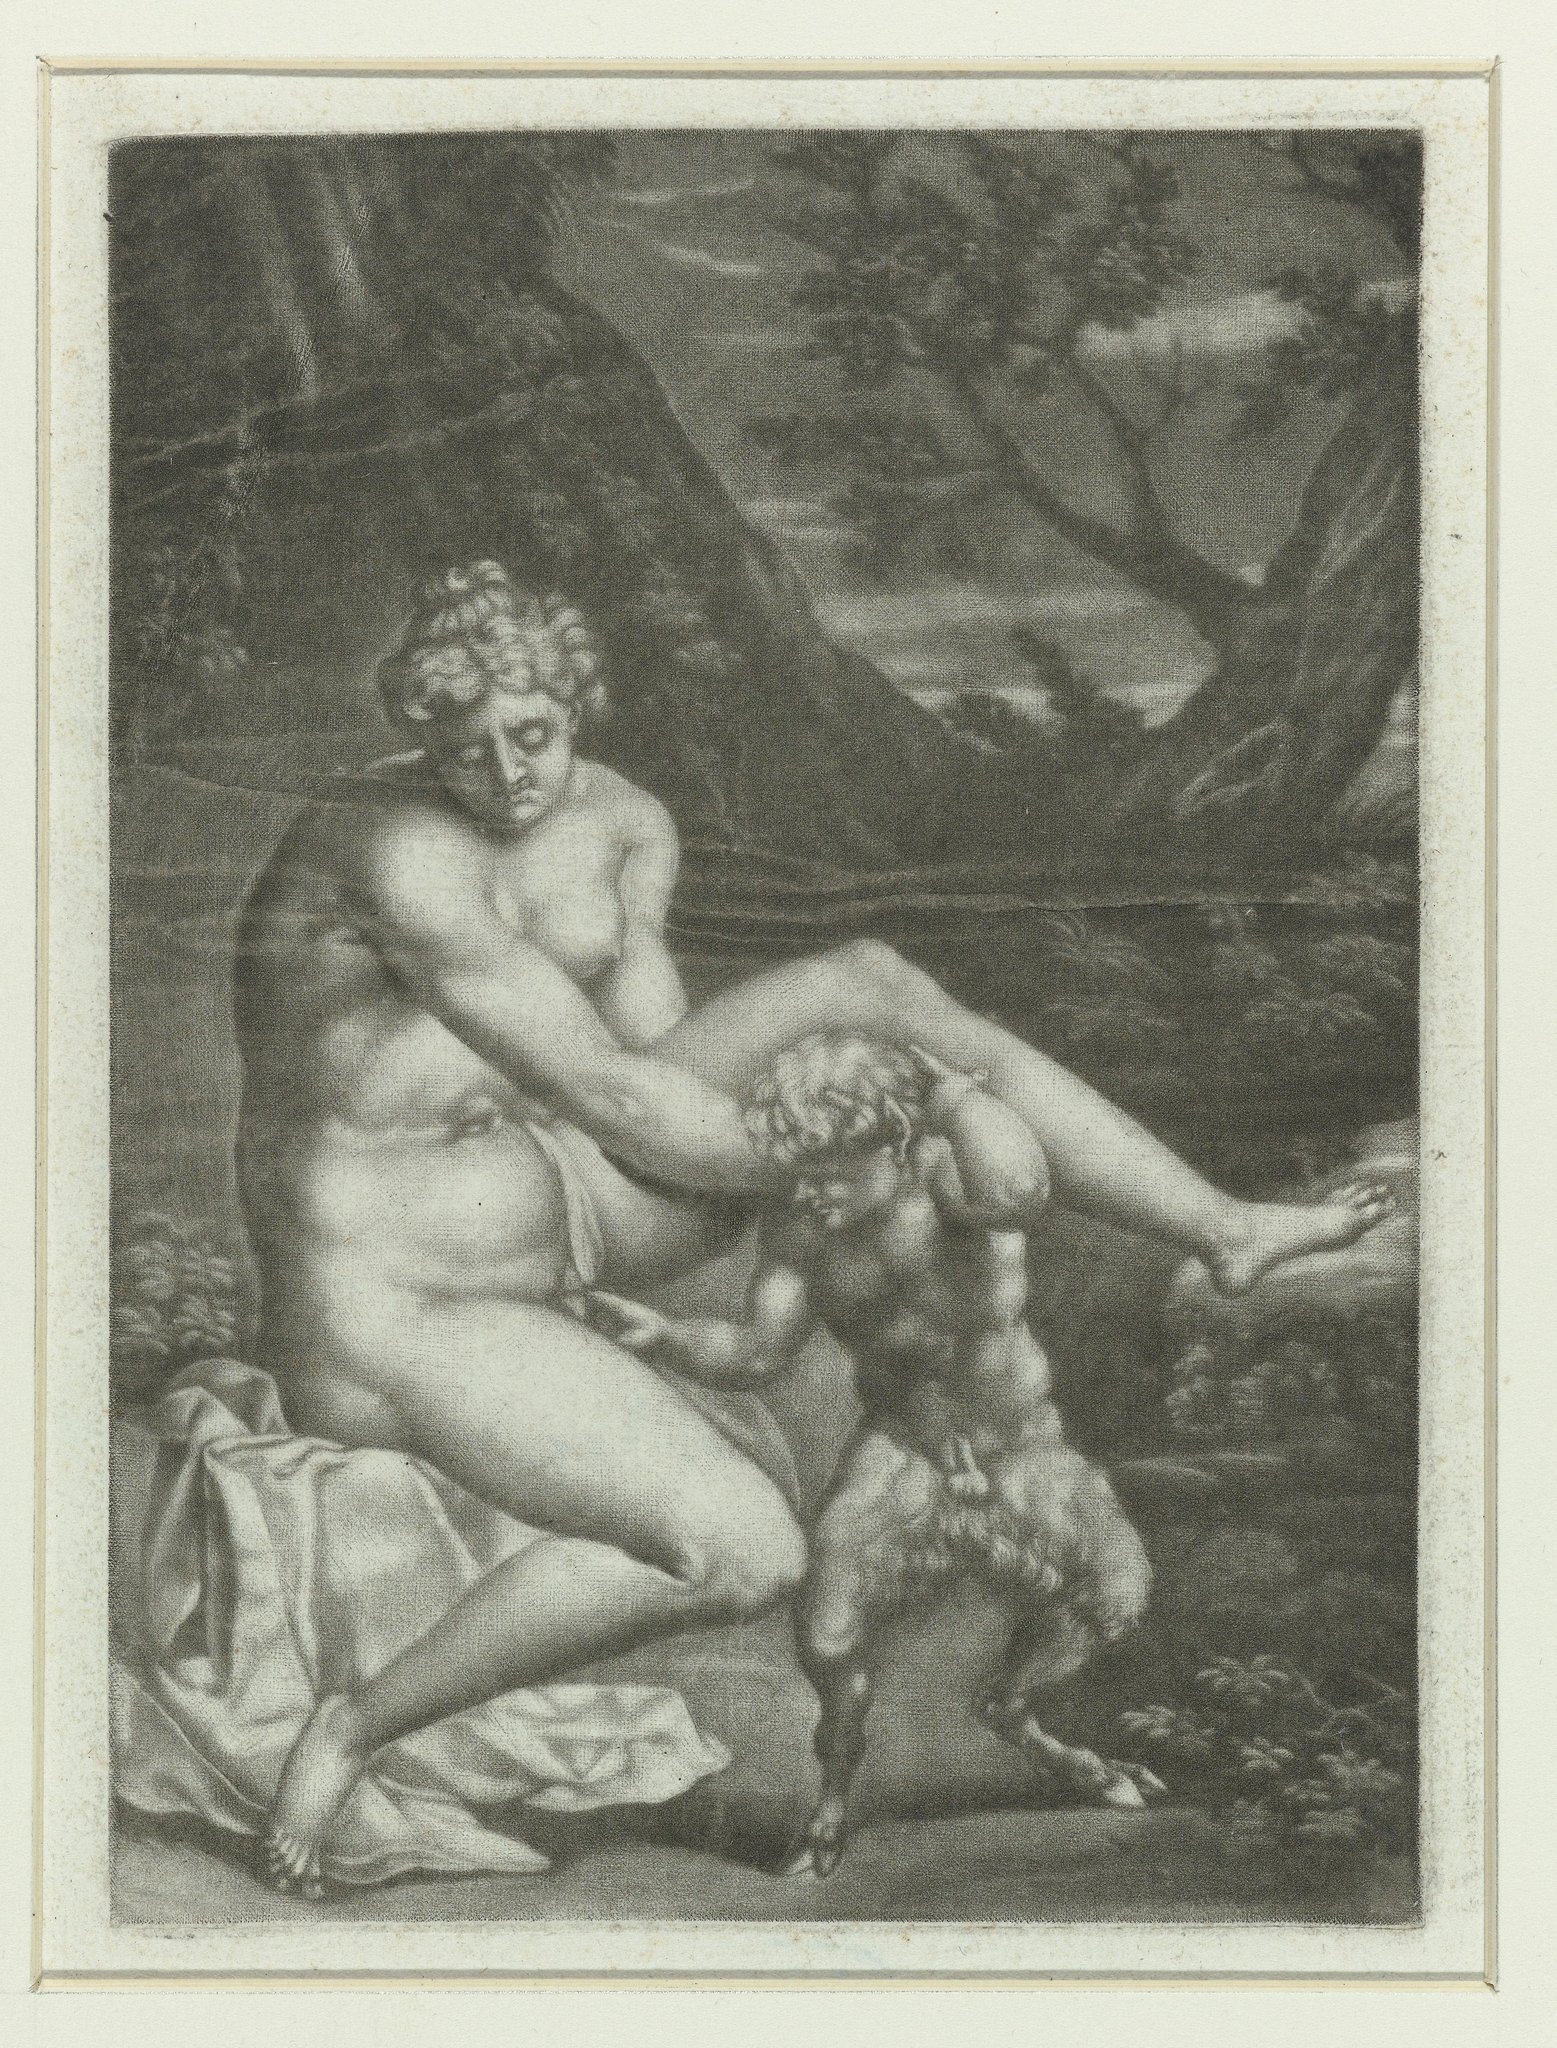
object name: print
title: Nimf en kleine faun als liefdespaar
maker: Anonymous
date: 1642-1750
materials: paper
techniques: mezzotint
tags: sexual organs (human), partially clothed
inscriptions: collector's mark: Lugt 2228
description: Een kleine faun raakt het vrouwelijke geslachtsdeel van een naakte nimf aan.